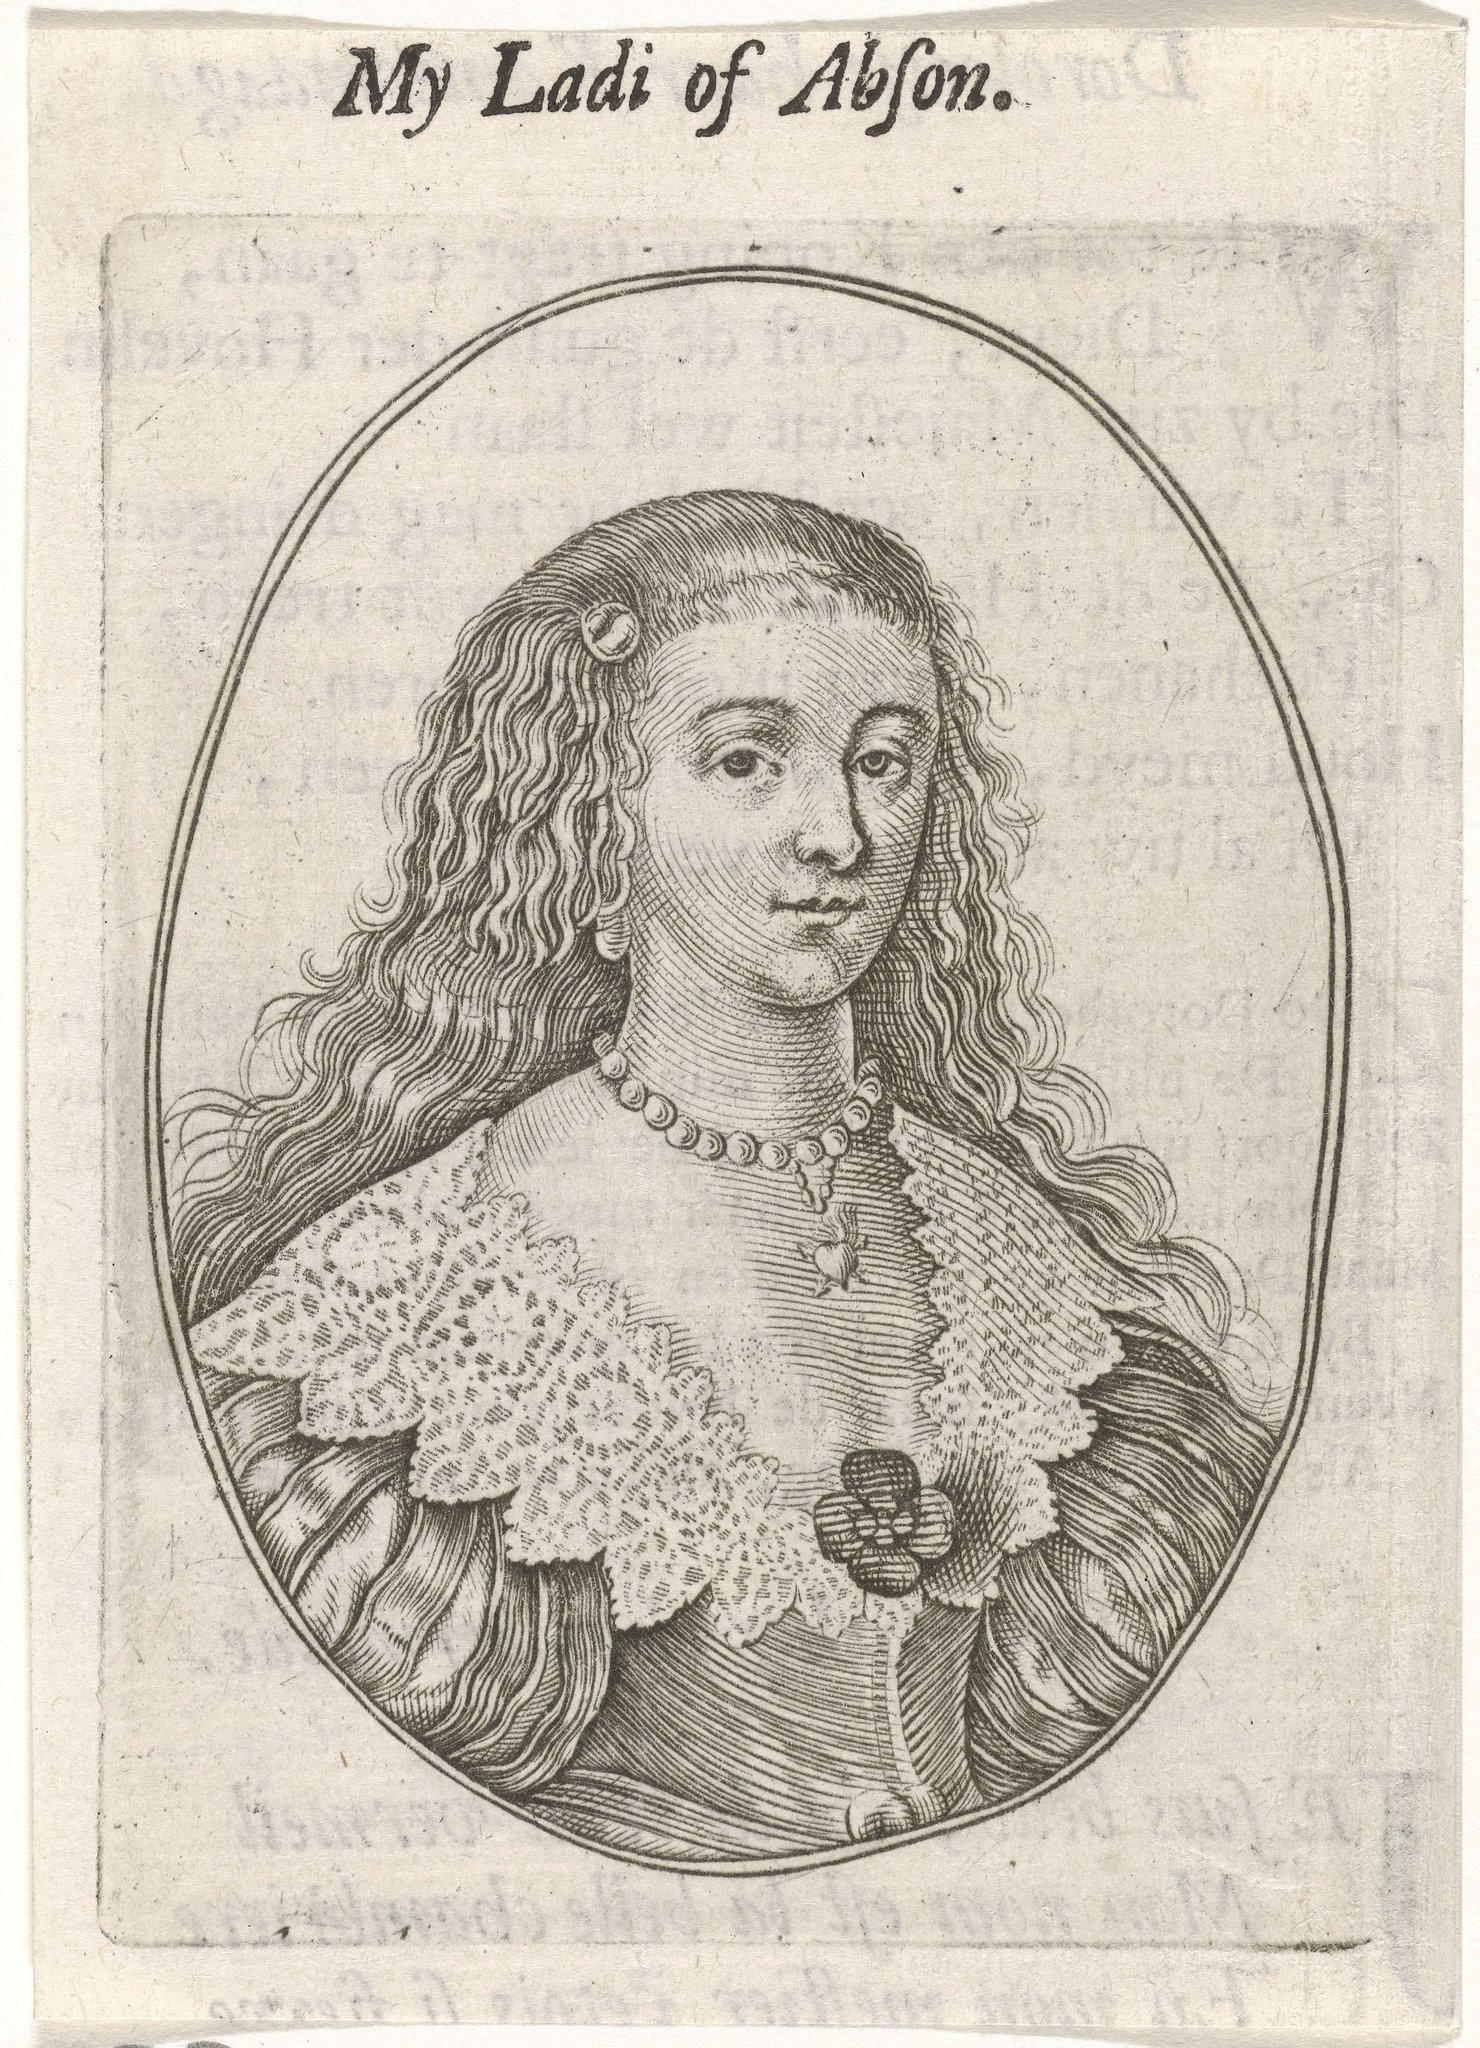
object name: costume print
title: Le miroir des courtisannes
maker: Anonymous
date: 1630-1710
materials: paper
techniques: engraving, letterpress printing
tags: whore, prostitute - cc - male prostitution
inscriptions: collector's mark: Lugt 2228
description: Prent gemaakt voor: Le miroir des courtisannes de ce temps. Verschillende edities van dit werk, uitgegeven tussen 1630 en 1710, maken gebruik van de gravures van Van der Passe óf van spiegelbeeldige kopieën ervan.